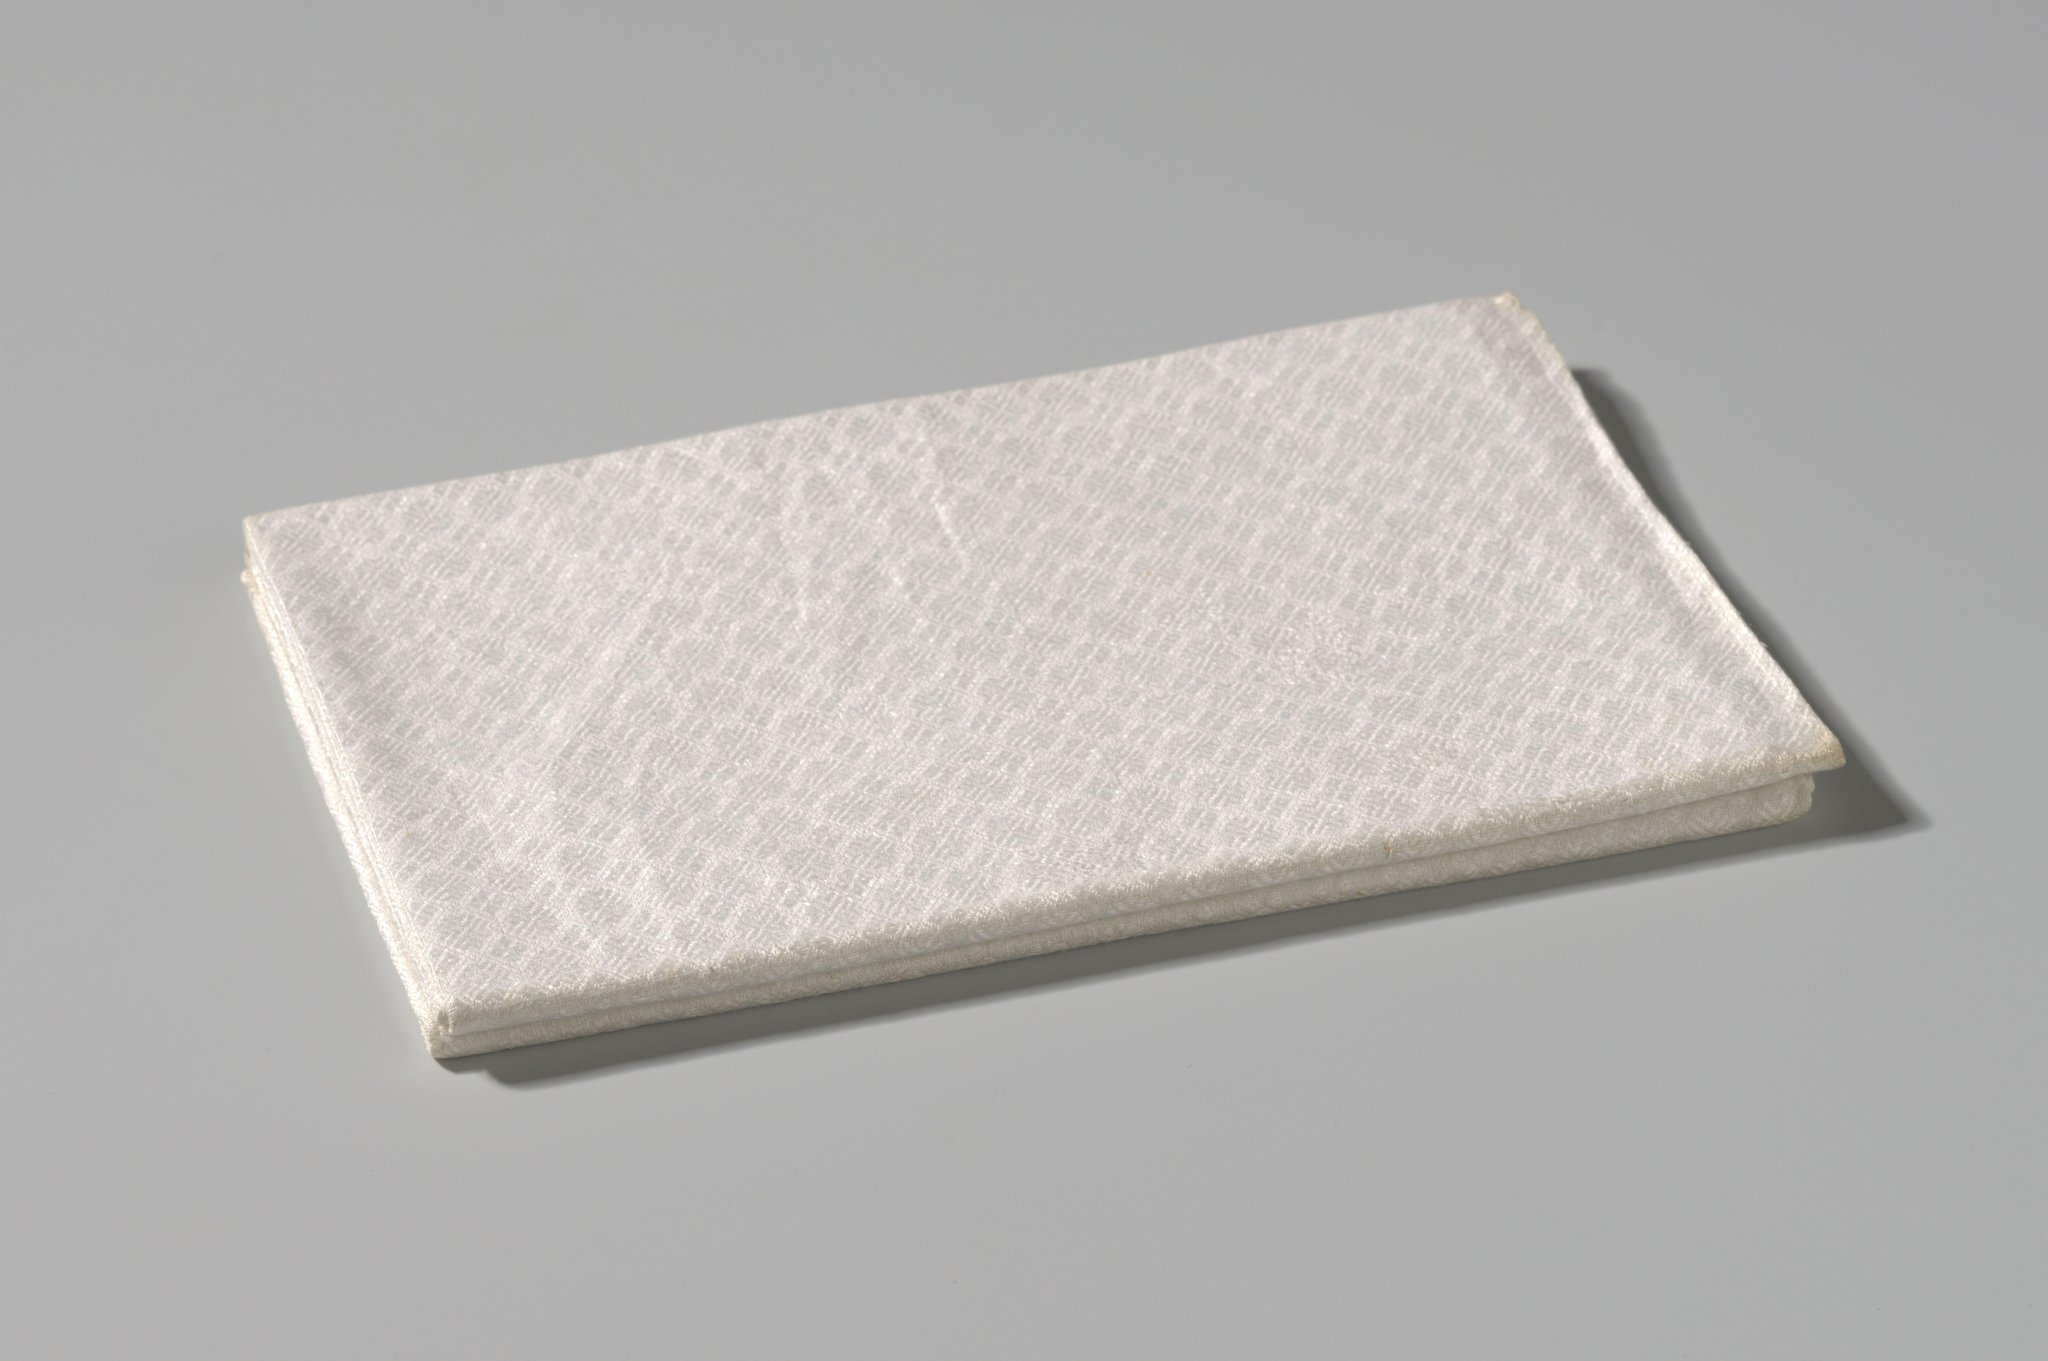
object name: napkin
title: Servet van wit linnen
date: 1767-1816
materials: linen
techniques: weave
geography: northern netherlands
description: Wit linnen servet met een kepervariatie-patroon, merk WS 36.